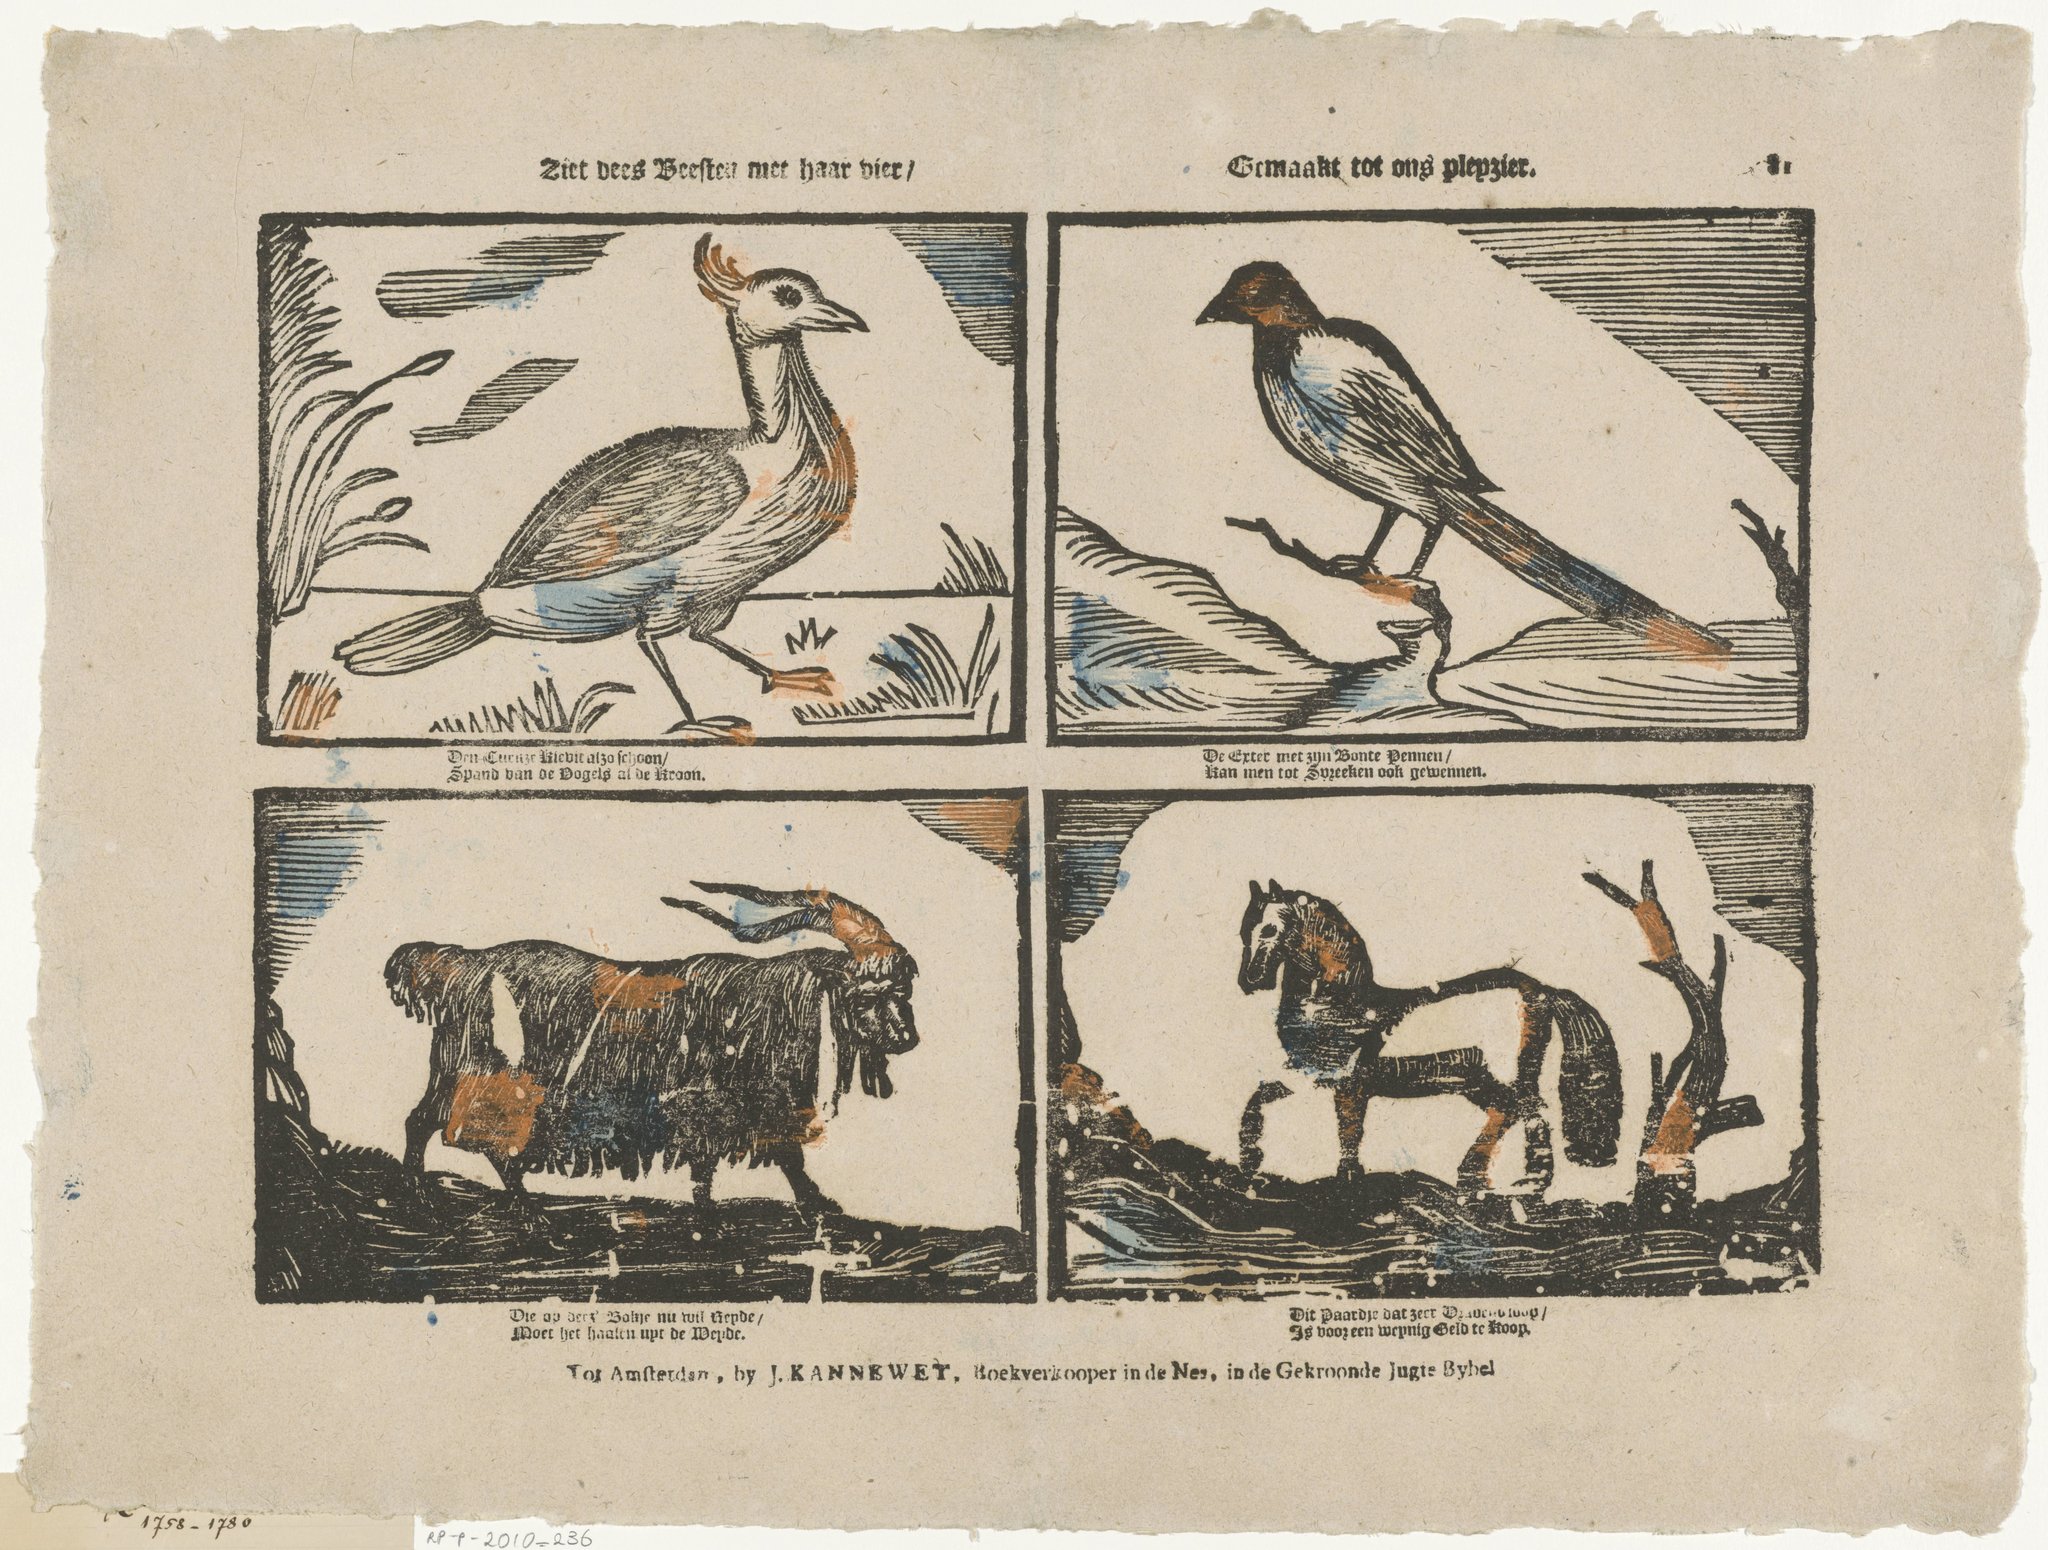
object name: print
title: Ziet dees beesten mee haar vier / Gemaakt tot ons pleyzier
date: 1725-1780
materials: paper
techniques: colour, letterpress printing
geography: amsterdam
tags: animals, birds, he-goat, billy-goat, horse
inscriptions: collector's mark: Lugt 2228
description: Blad met 4 voorstellingen van twee verschillende vogels, een bok en een paard. Onder elke afbeelding een tweeregelig vers. Genummerd rechtsboven: 81